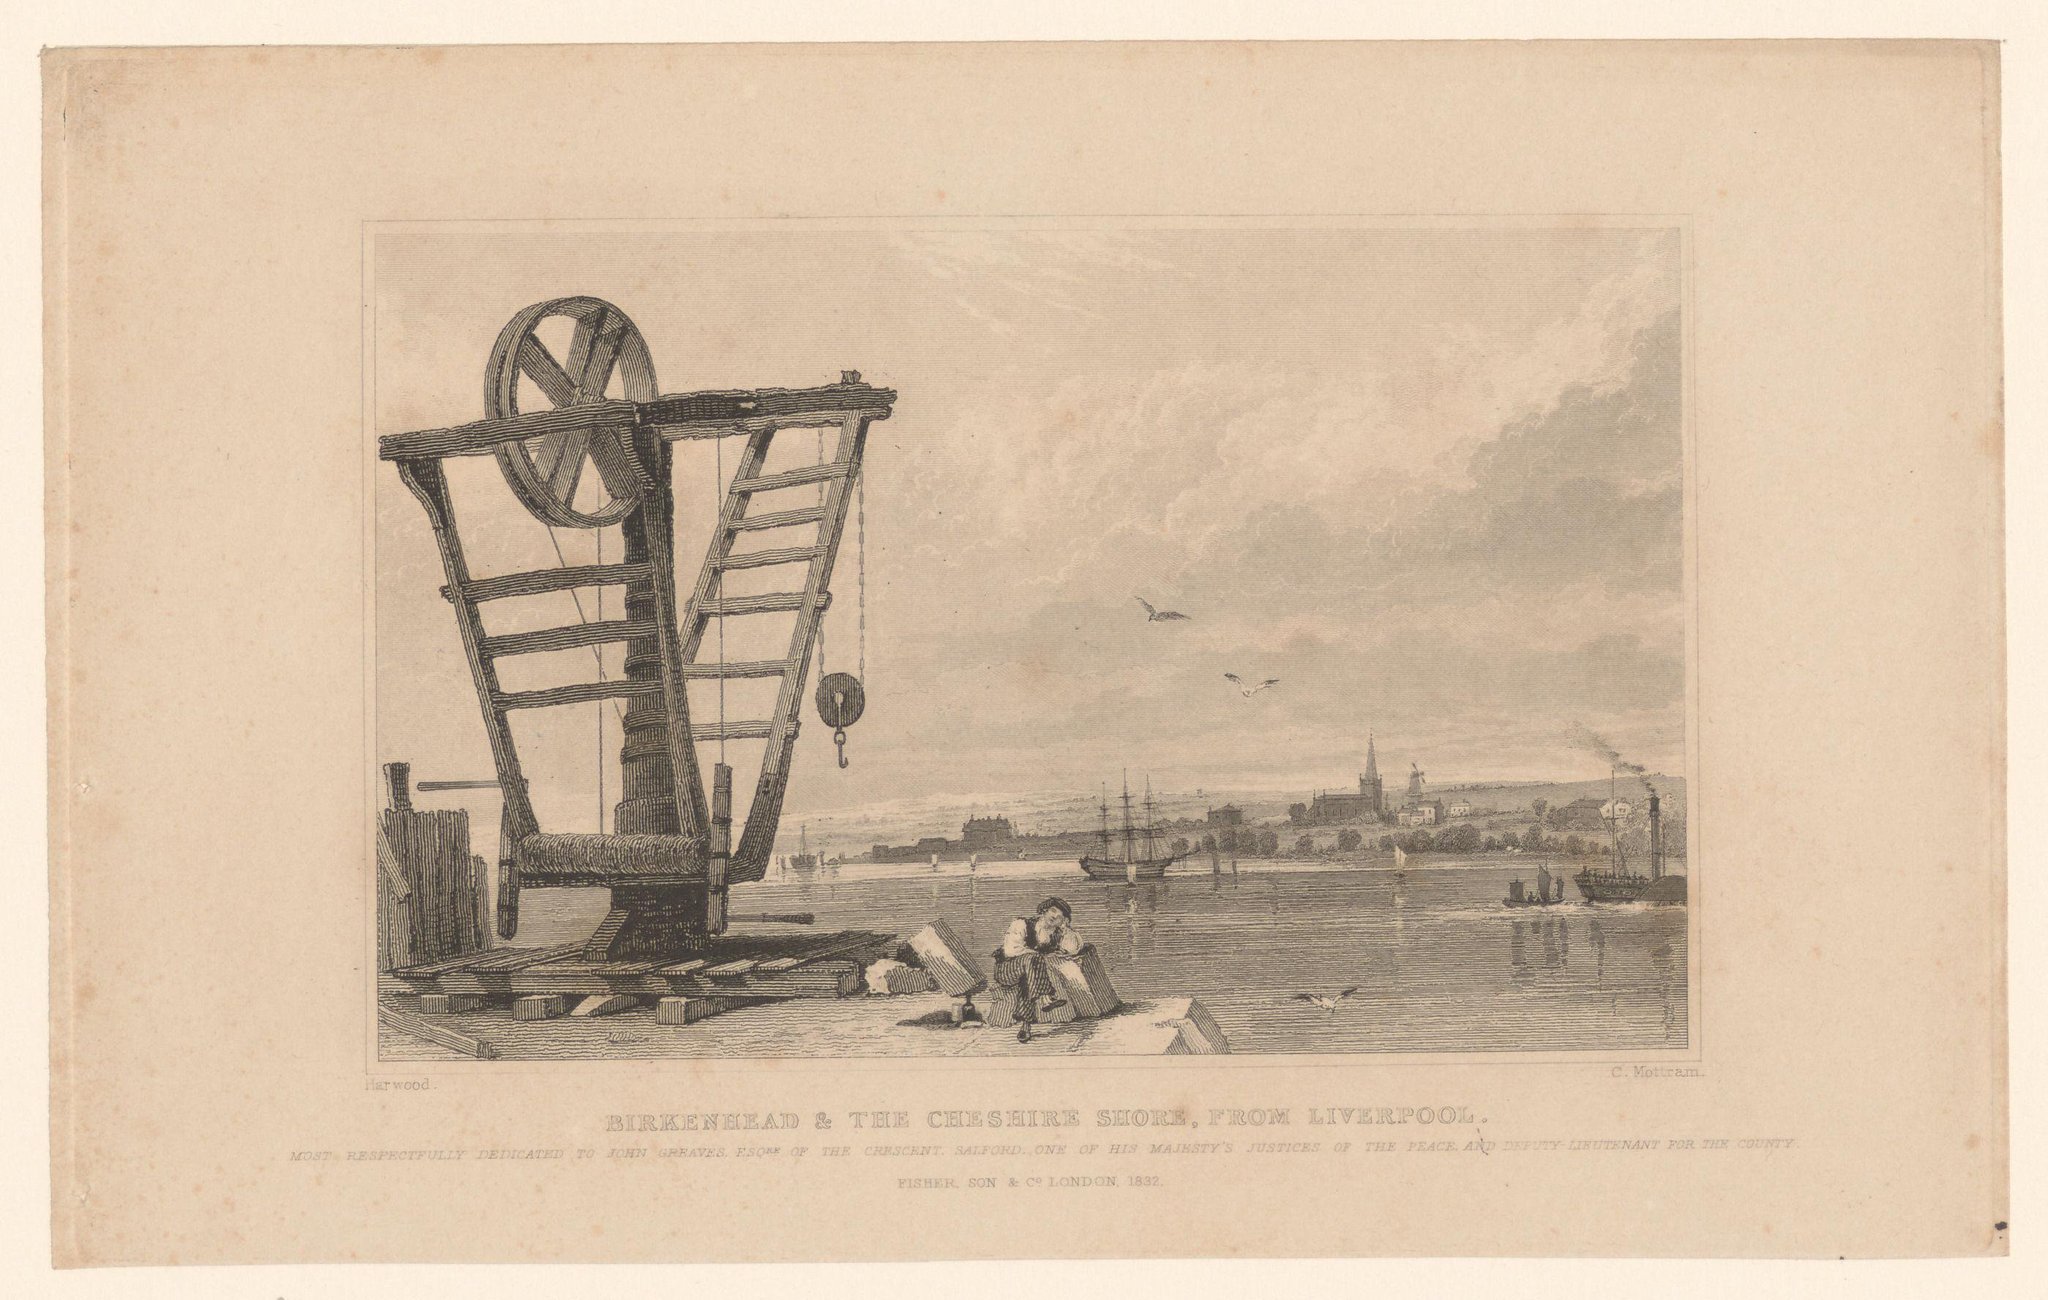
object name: print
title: Gezicht op Birkenhead vanaf Liverpool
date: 1832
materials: paper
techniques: etching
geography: london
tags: harbour, city-view, and landscape with man-made constructions, birkenhead (merseyside)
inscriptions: collector's mark: Lugt 2228